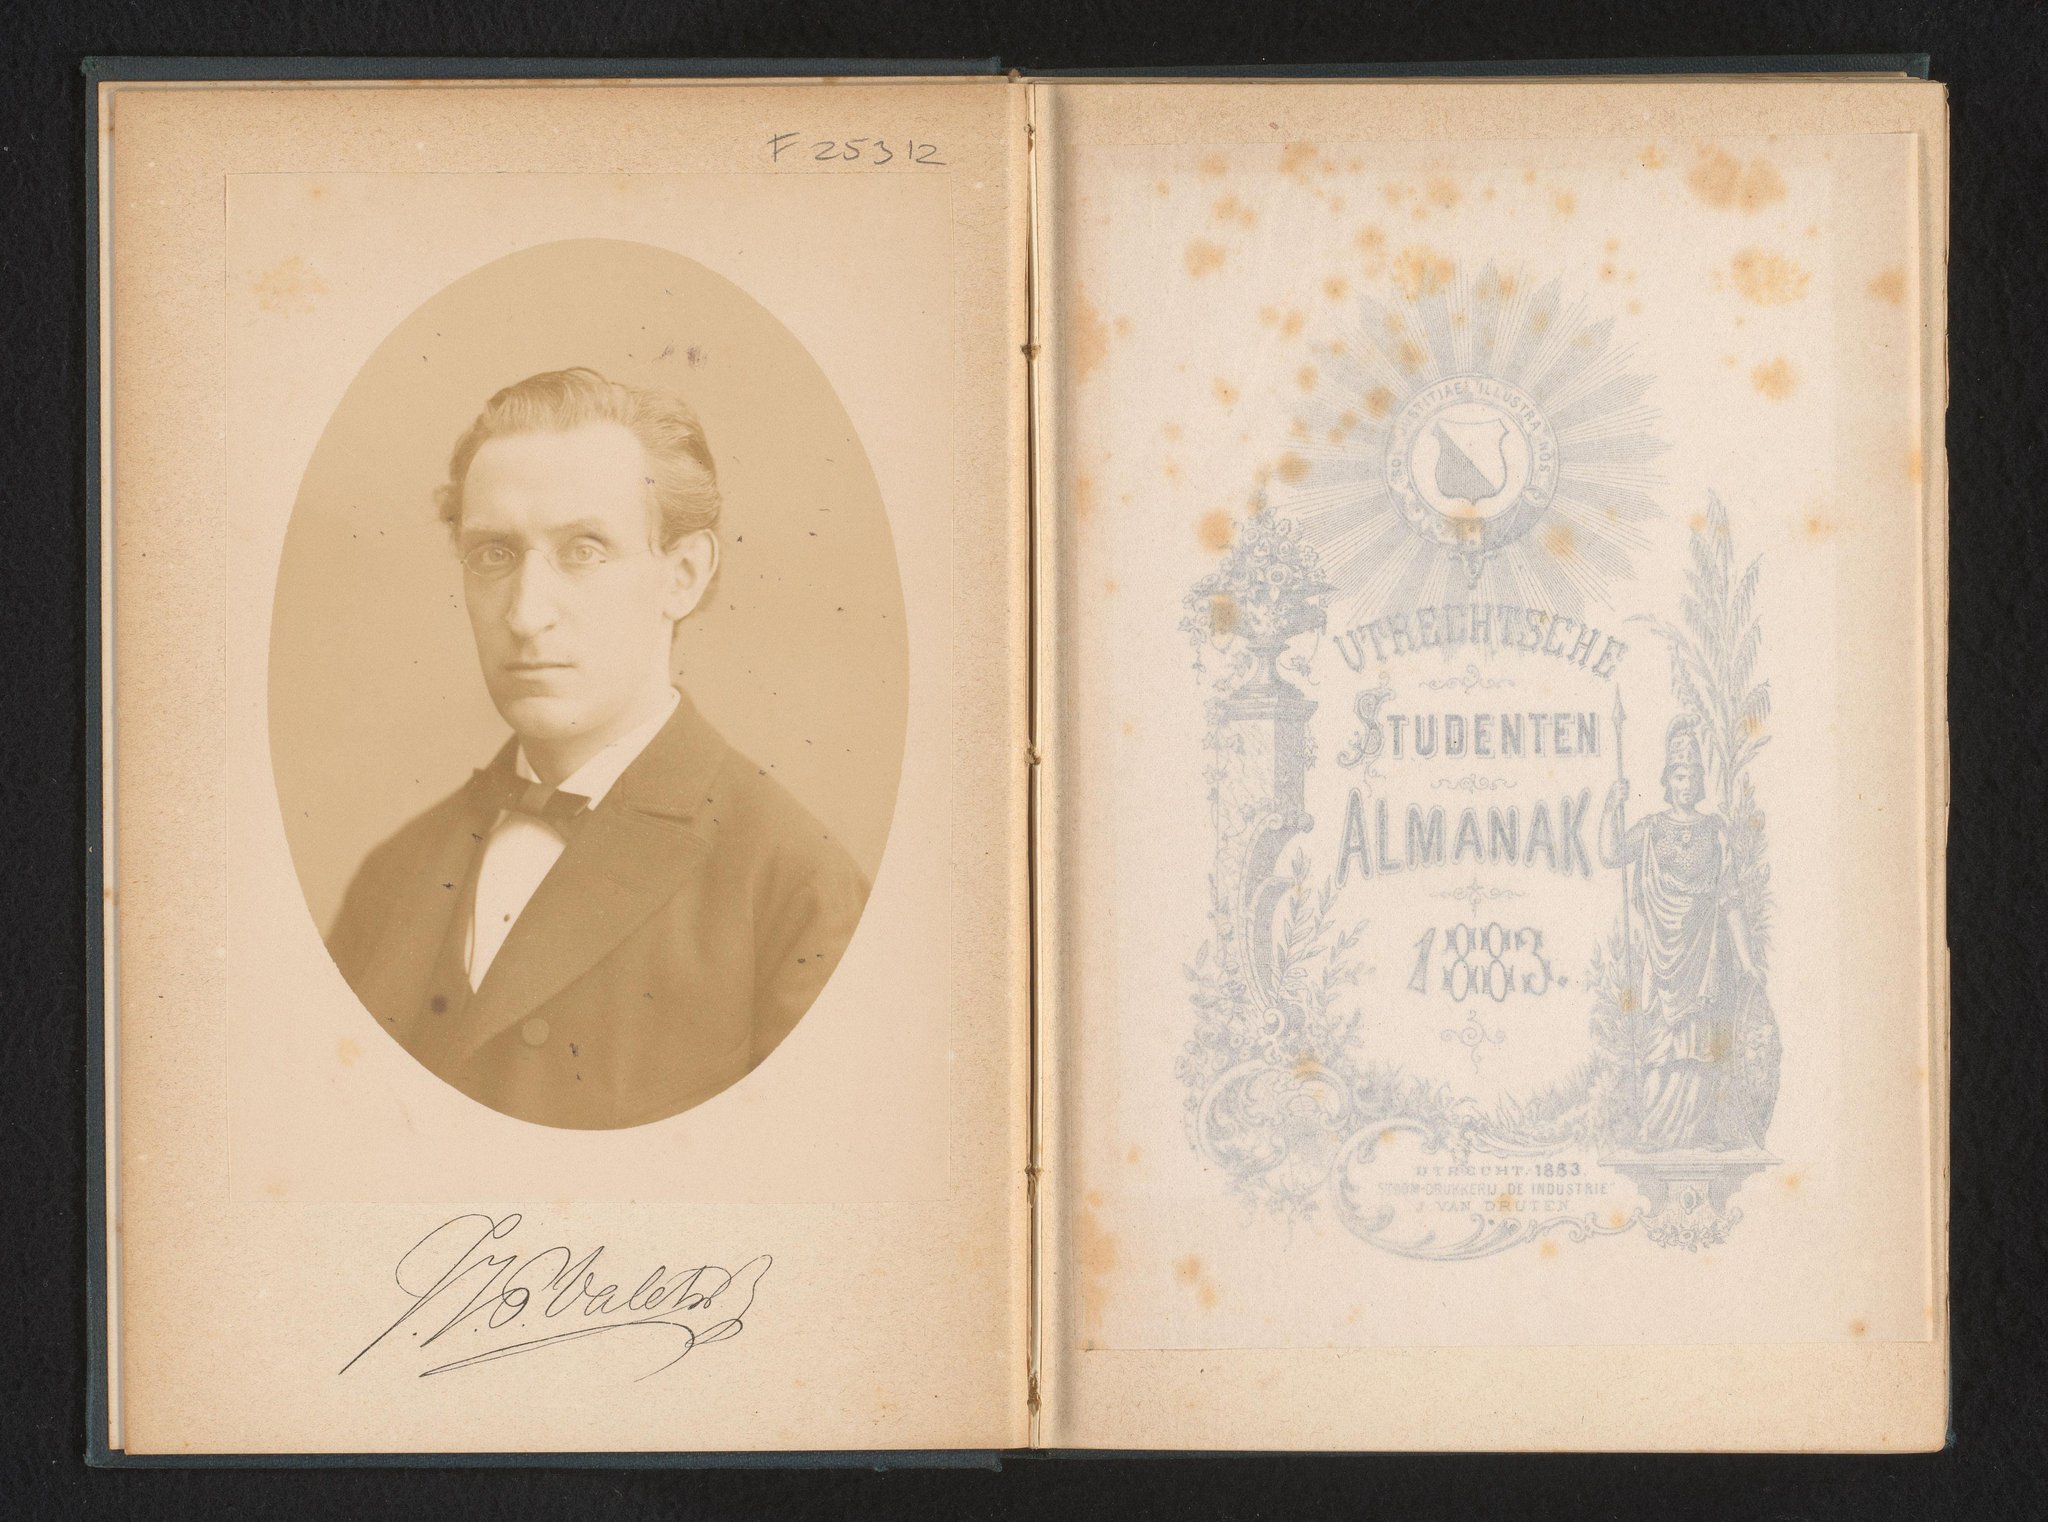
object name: photograph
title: Portret van J.J.P. Valeton, hoogleraar godgeleerdheid en rector magnificus van de Universiteit Utrecht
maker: Anonymous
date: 1882-1883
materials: paper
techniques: albumen print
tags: utrecht, historical persons, professor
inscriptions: signature: ‘J.J.P. Valeton’